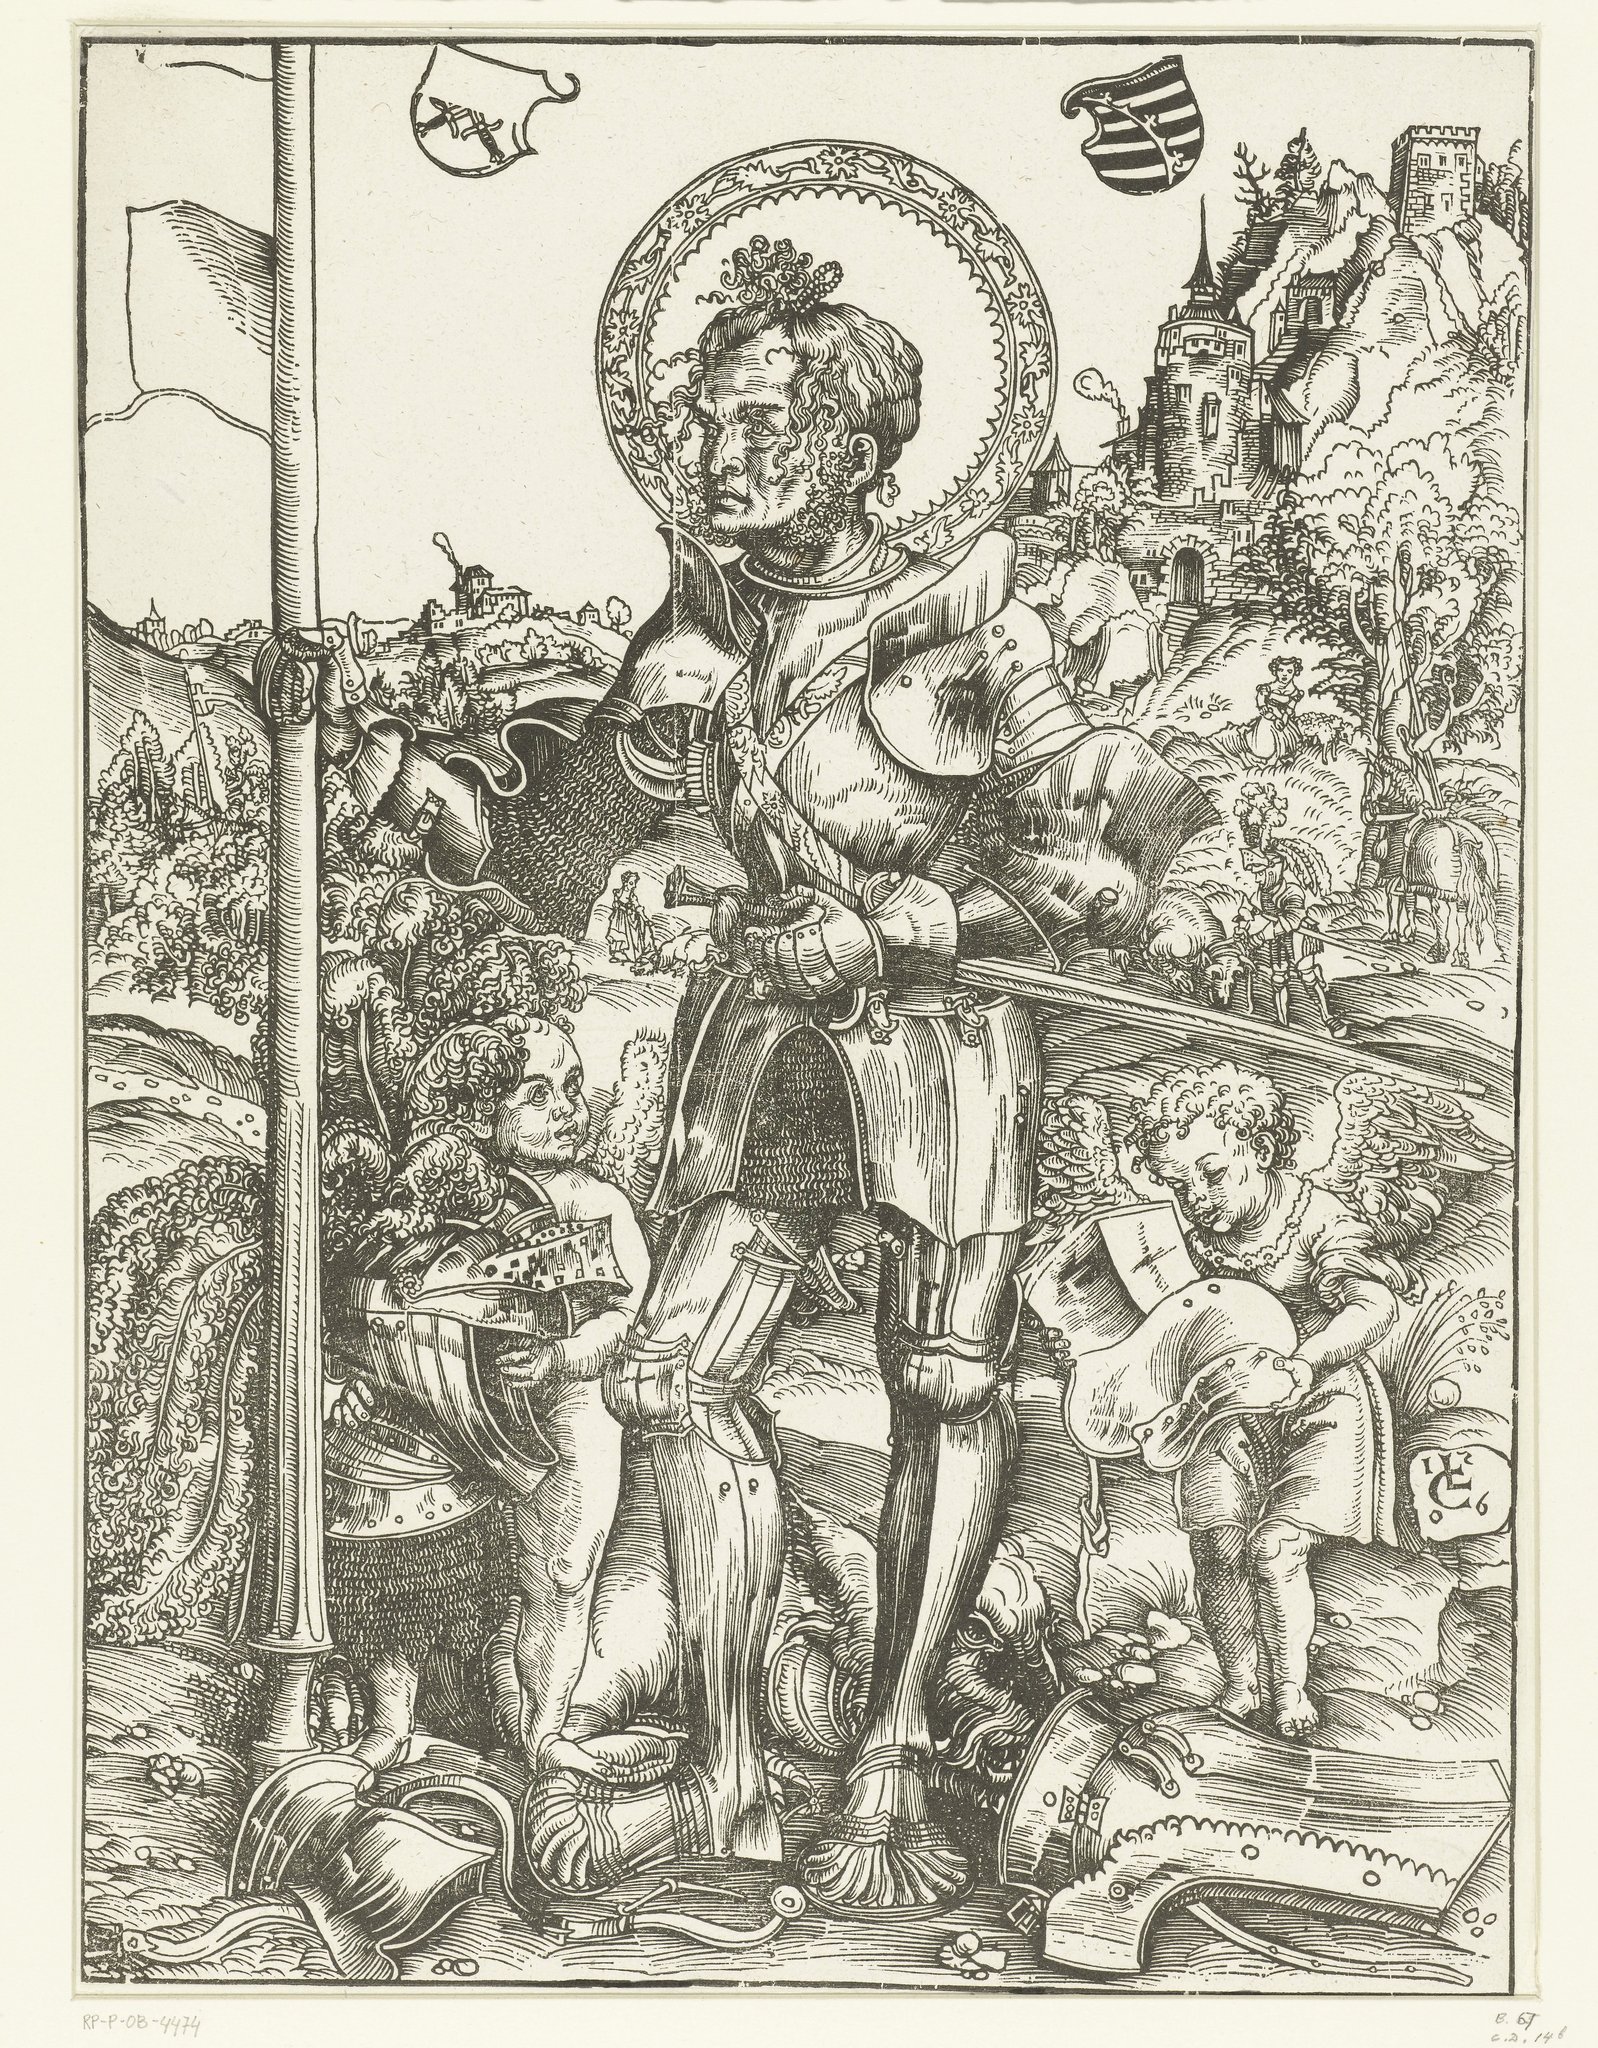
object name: print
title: Joris (Georgius) staand met lans en twee engelen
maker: lucas cranach (i)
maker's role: draughtsman, print maker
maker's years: 1472-1553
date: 1506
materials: paper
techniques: woodcut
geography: germany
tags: the warrior martyr george (georgius); possible attributes: banner (red cross on white field), (red) cross, dragon, (white) horse, broken lance, shield (with cross), sword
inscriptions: collector's mark: Lugt 240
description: De heilige Joris (Georgius) staat gekleed in een harnas en met een lans in zijn rechterhand in een landschap. Twee kleine engelen of putti houden onderdelen van het harnas vast, zoals een helm met veren, enkele delen liggen op de grond. Bovenaan zijn twee schilden met het keurvorstelijk en hertogelijk wapen van Saksen afgebeeld.